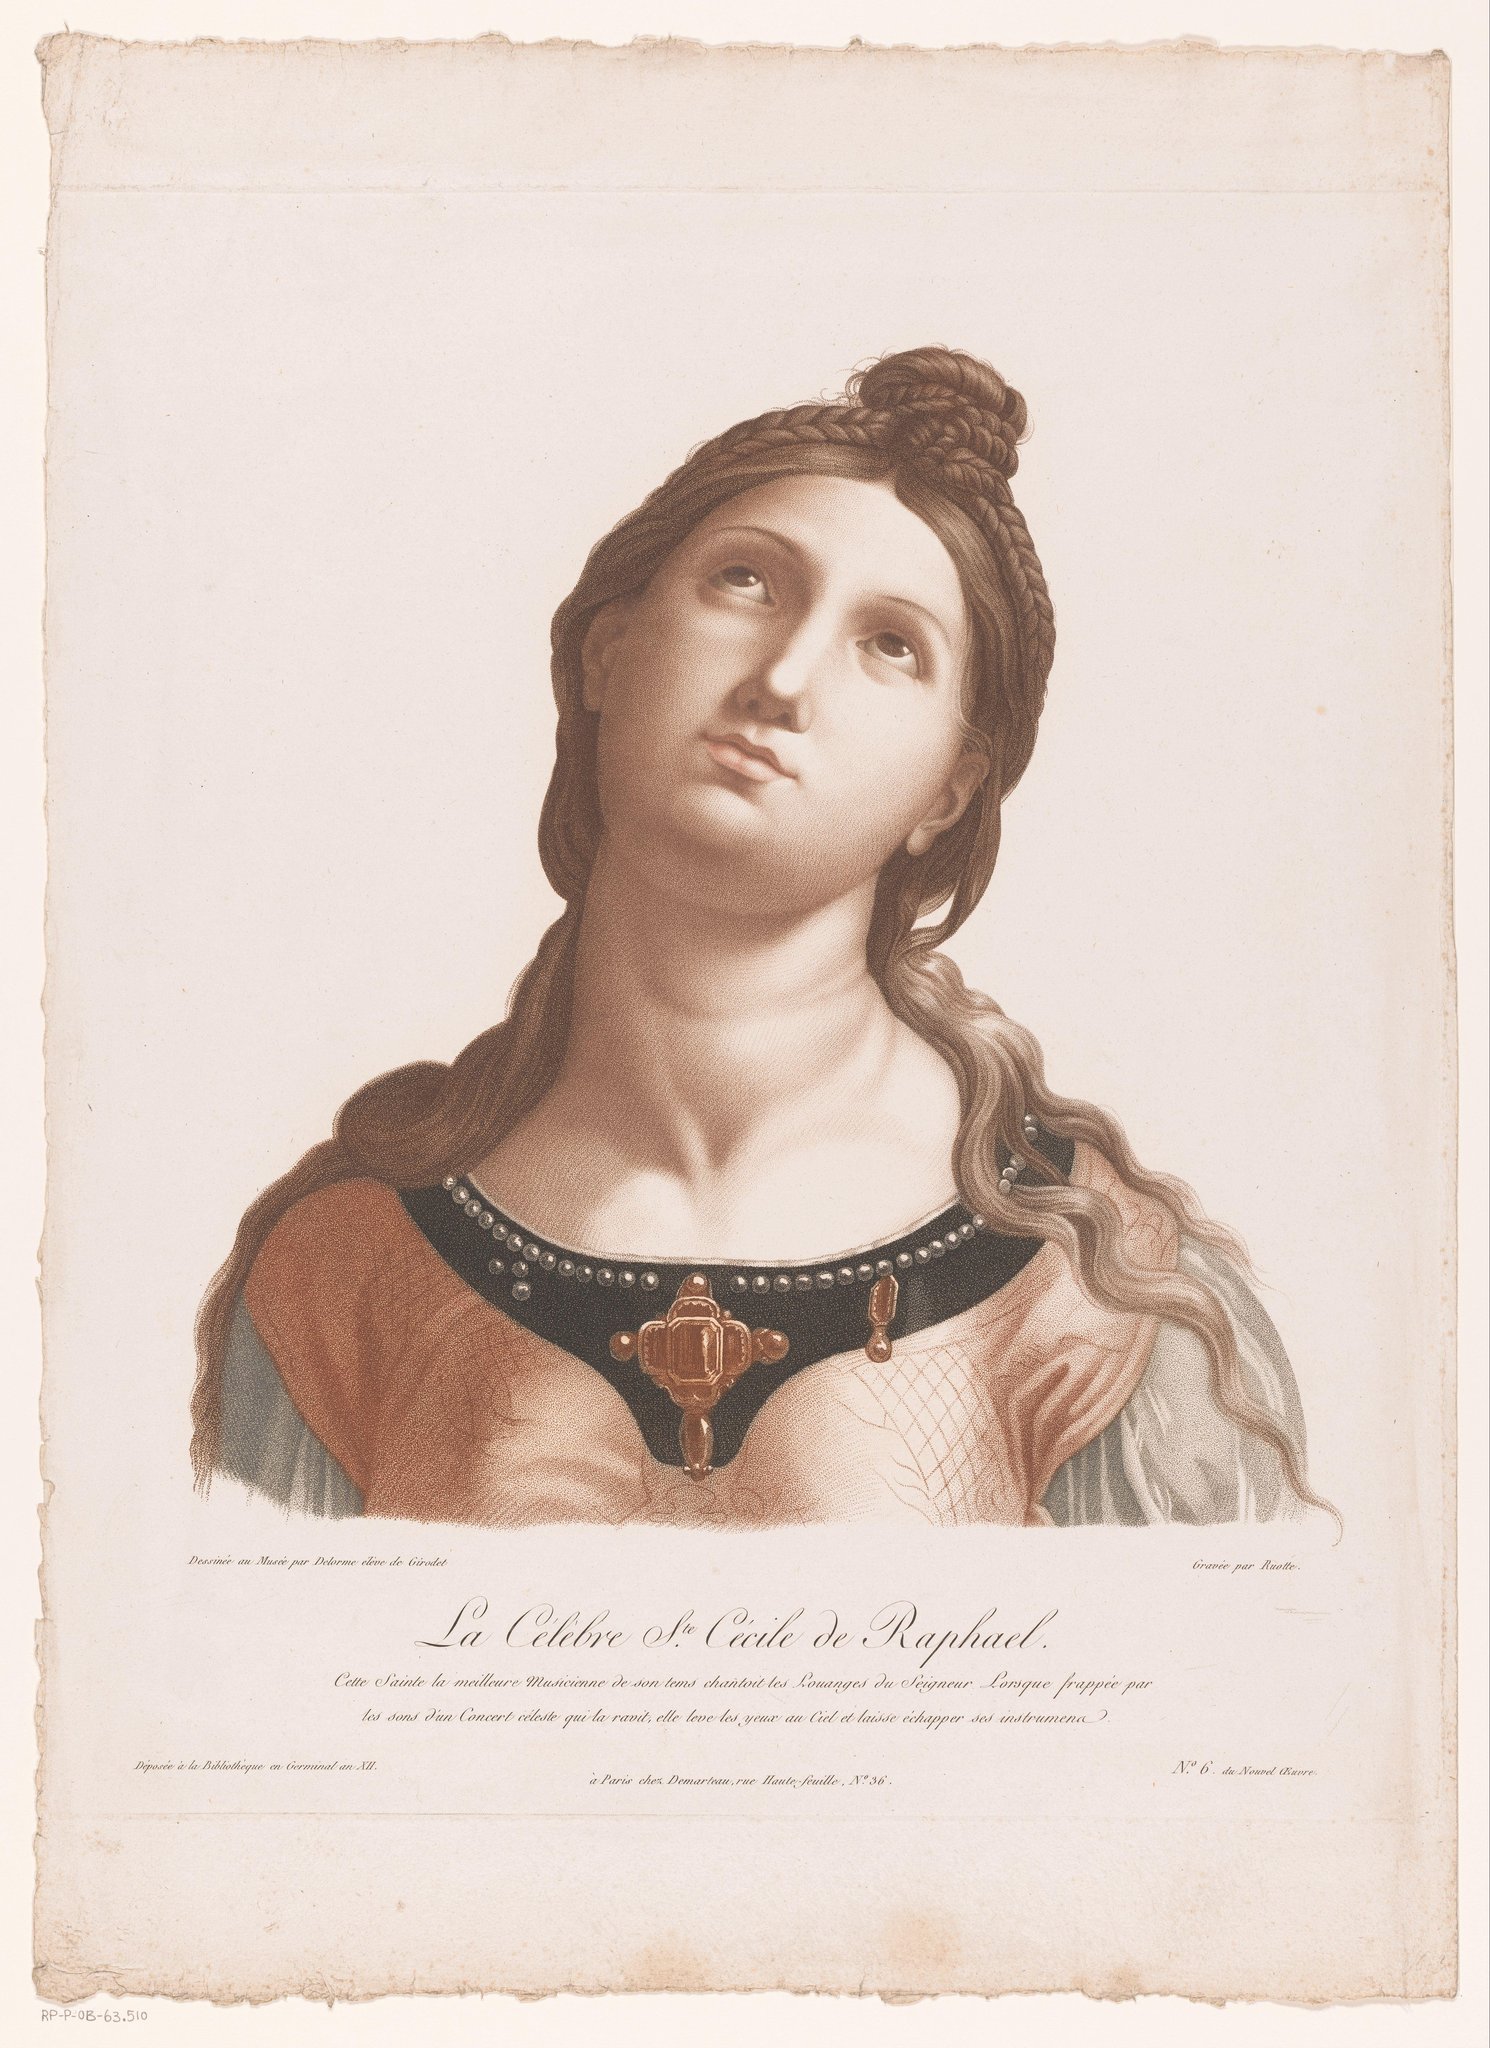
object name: print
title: Heilige Cecilia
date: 1764-1811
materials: paper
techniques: etching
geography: paris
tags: female saints (with name)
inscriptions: : ‘Déposée à la Bibliothèque en Germinal an XII’, collector's mark: Lugt 2228